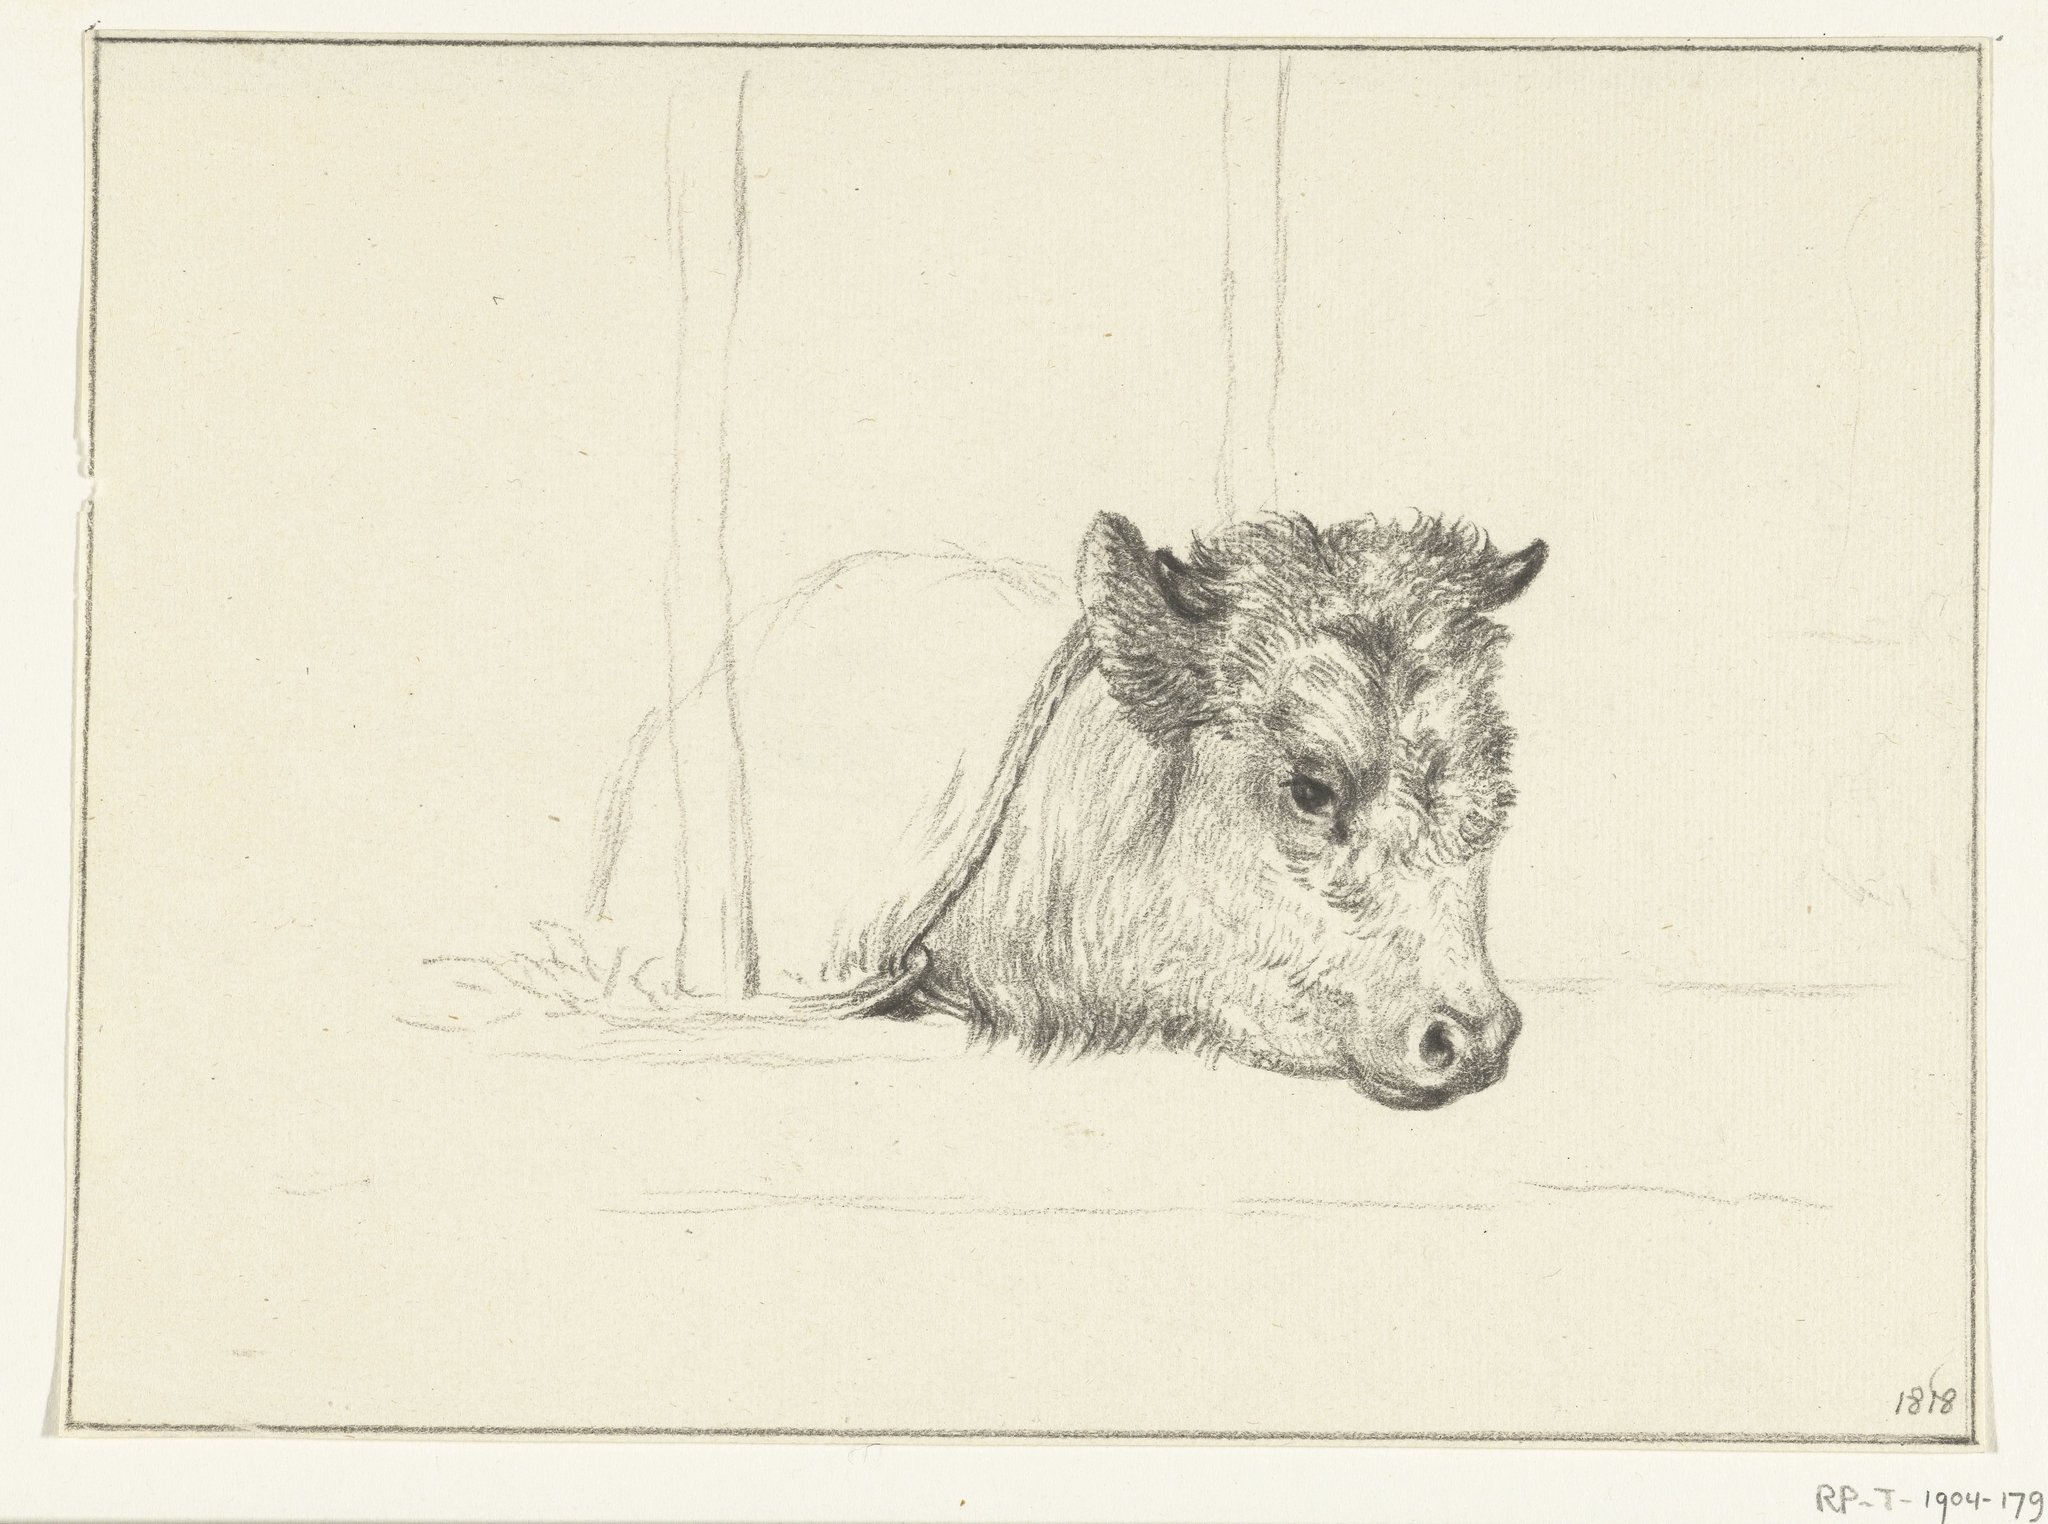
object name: drawing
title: Kop van een koe, liggend in een stal, naar rechts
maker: jean bernard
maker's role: draughtsman, print maker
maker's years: 1765-1833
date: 1818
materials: chalk, paper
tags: cow